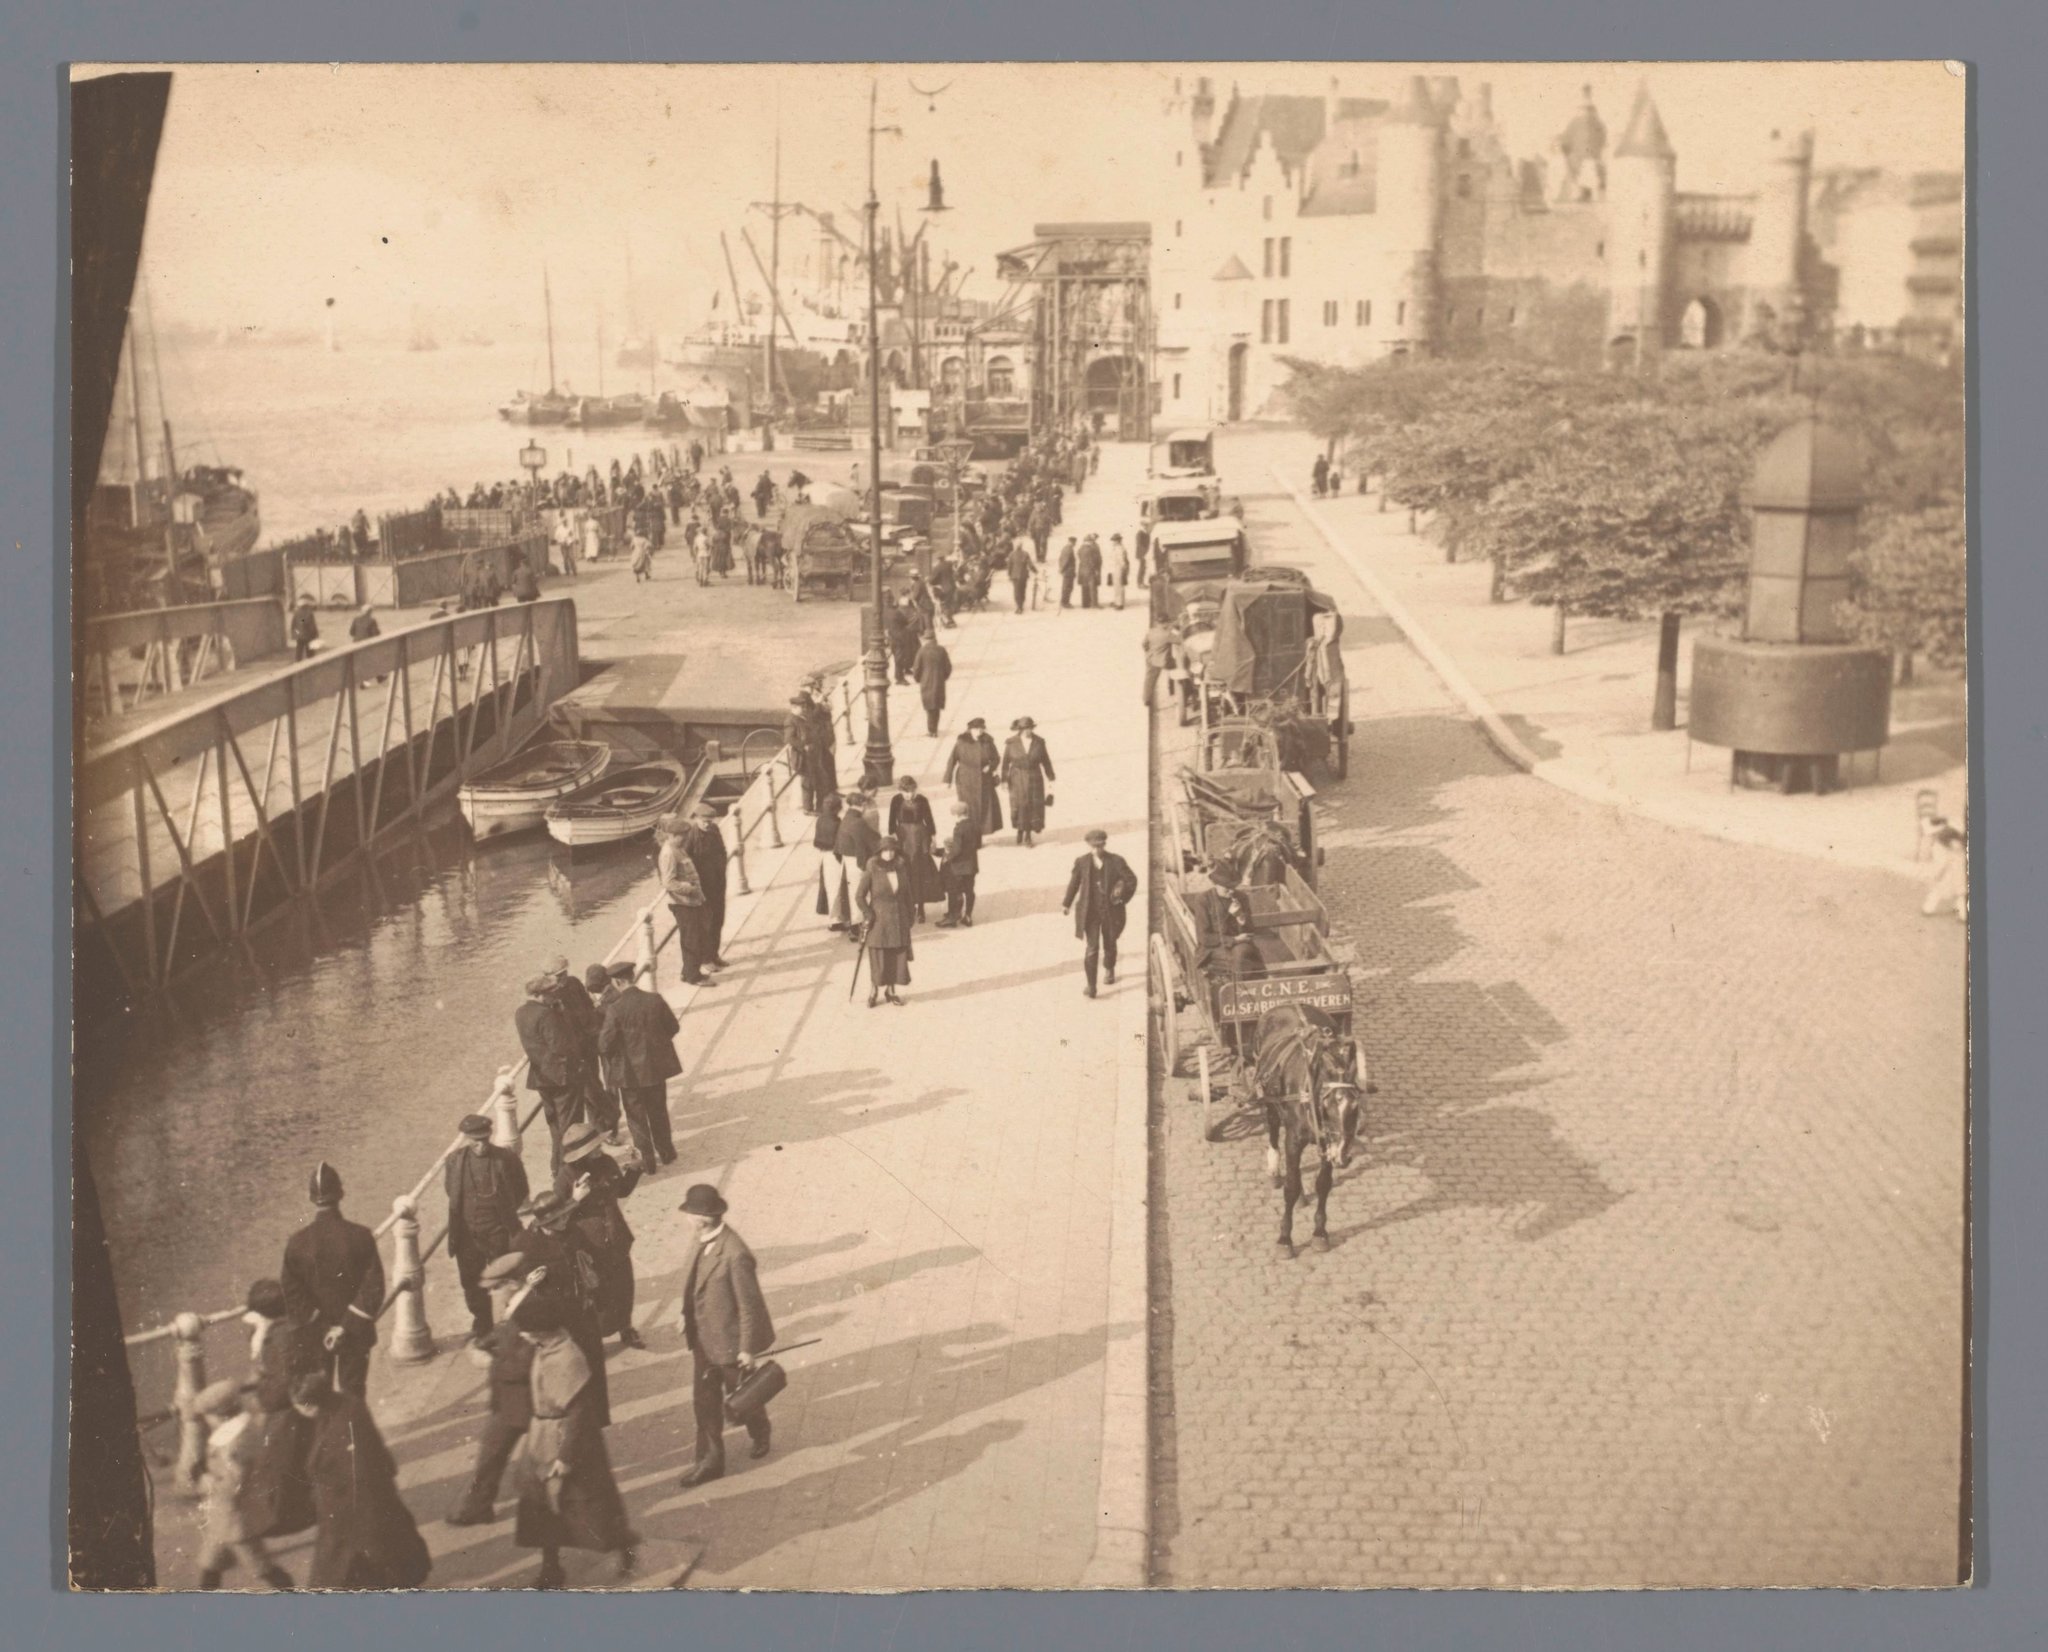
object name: photograph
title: Voetgangers op de kade van Antwerpen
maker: Anonymous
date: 1900-1940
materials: photographic support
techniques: gelatin silver print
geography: antwerp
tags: animal traction, animal-drawn vehicle (carriage etc.), pier, quay, wharf, antwerp